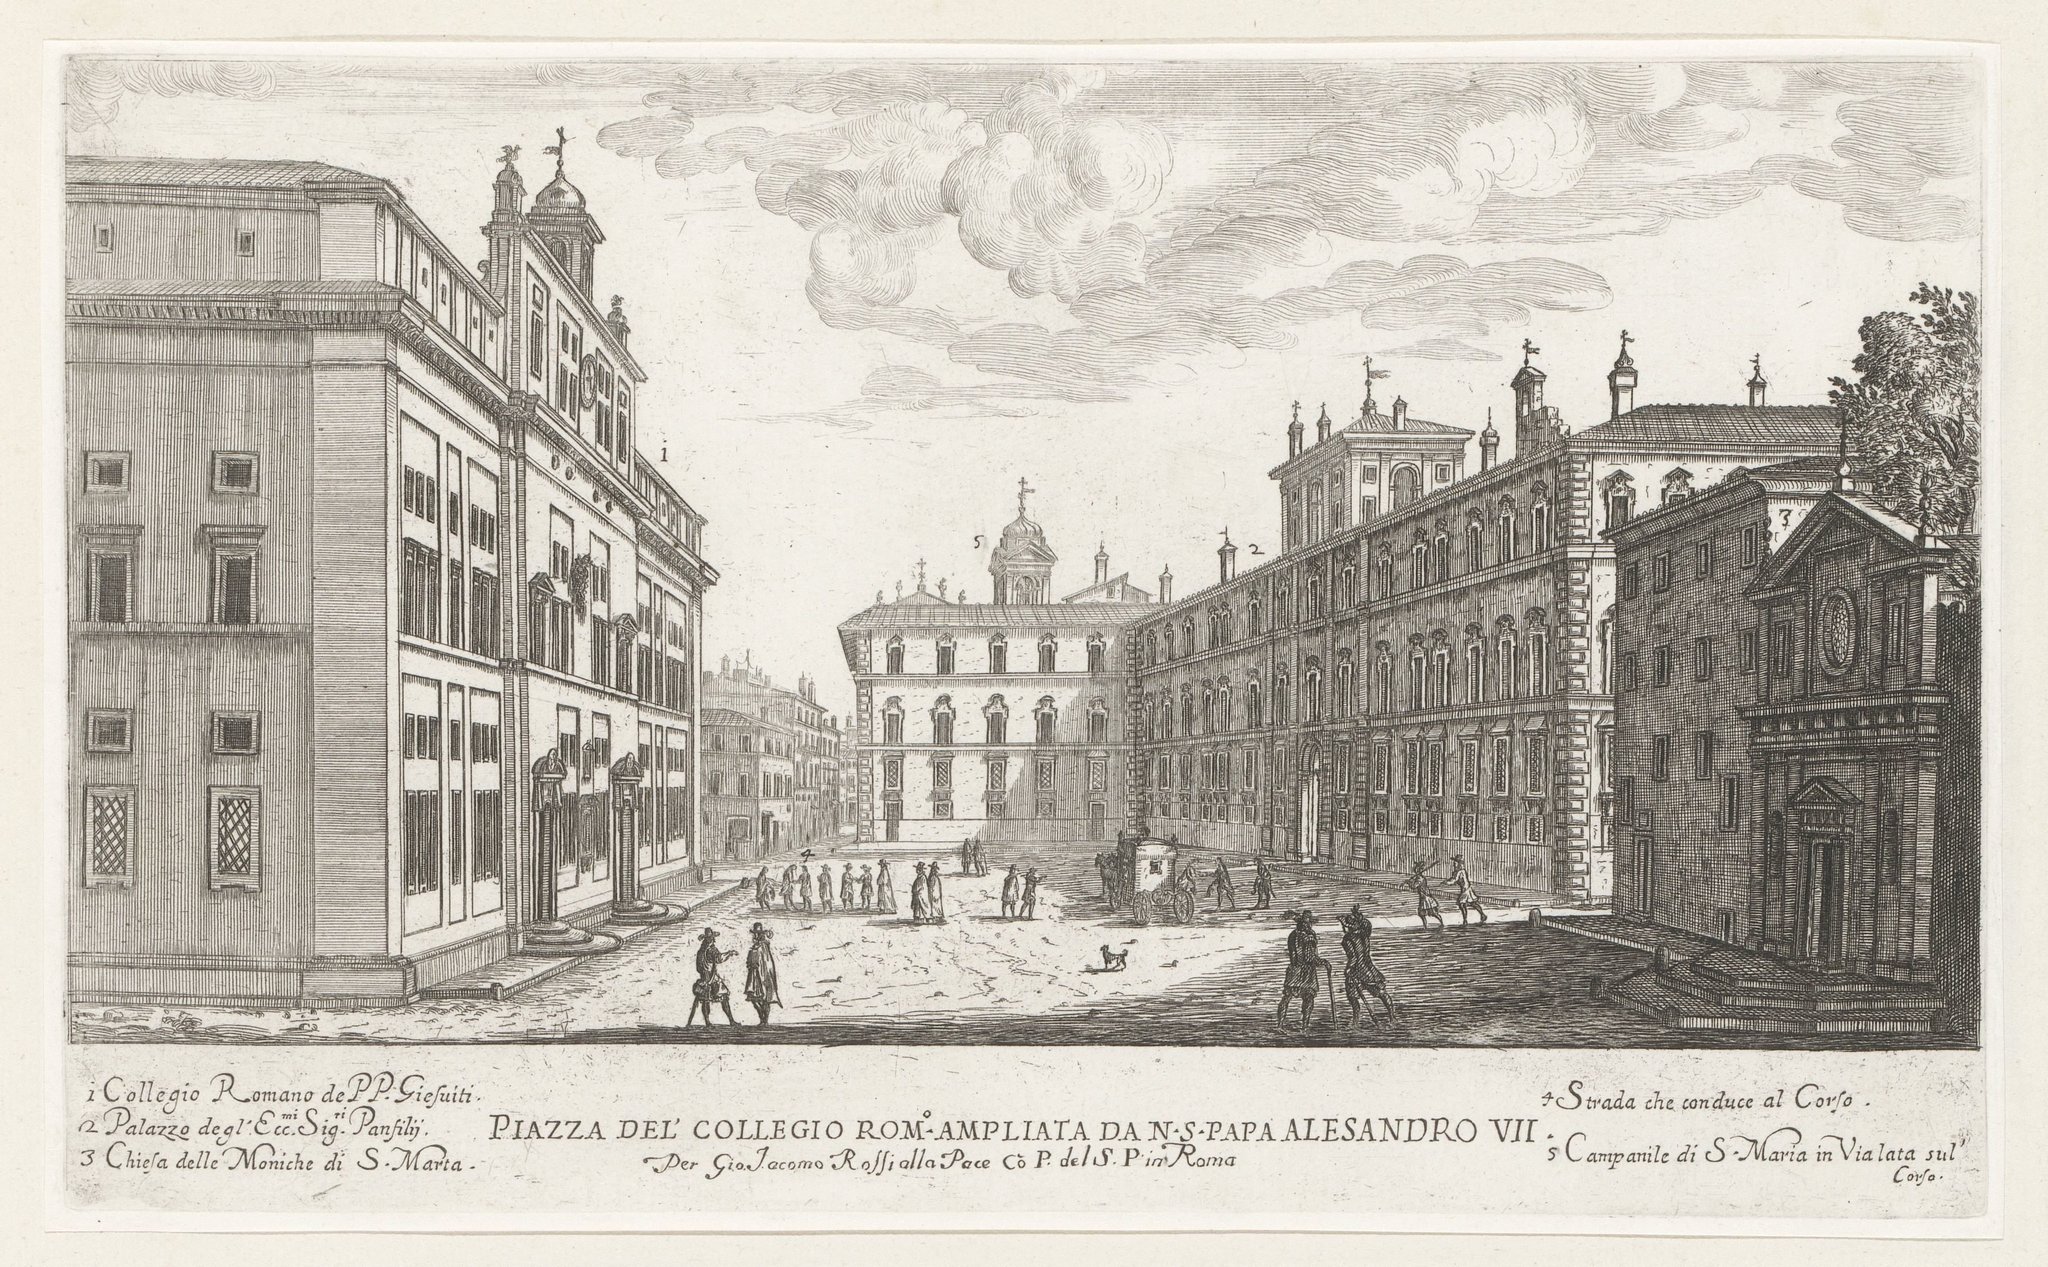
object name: print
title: Il nuovo teatro di Roma Moderna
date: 1665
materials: paper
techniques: etching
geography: rome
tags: square, place, circus, etc., city-view, and landscape with man-made constructions, rome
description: Deze prent maakt deel uit van een reeks bestaande uit vijf delen, waarvan de eerste drie delen bestaan uit prenten van Giovanni Battista Falda. Deel één bevat 25 prenten (+ titelprent en opdracht) (1665), deel twee bevat 15 prenten (+ titelprent en opdracht) (1665-67) en deel drie bevat 38 prenten (+ titelprent en opdracht) (1669-70). Delen vier en vijf bevatten prenten door Alessandro Specchi en Giovanni Domenico Campiglia. De originele drukplaten voor de eerste drie delen worden bewaard in de Calcografia Nazionale in Rome (inv. nr. 1414).